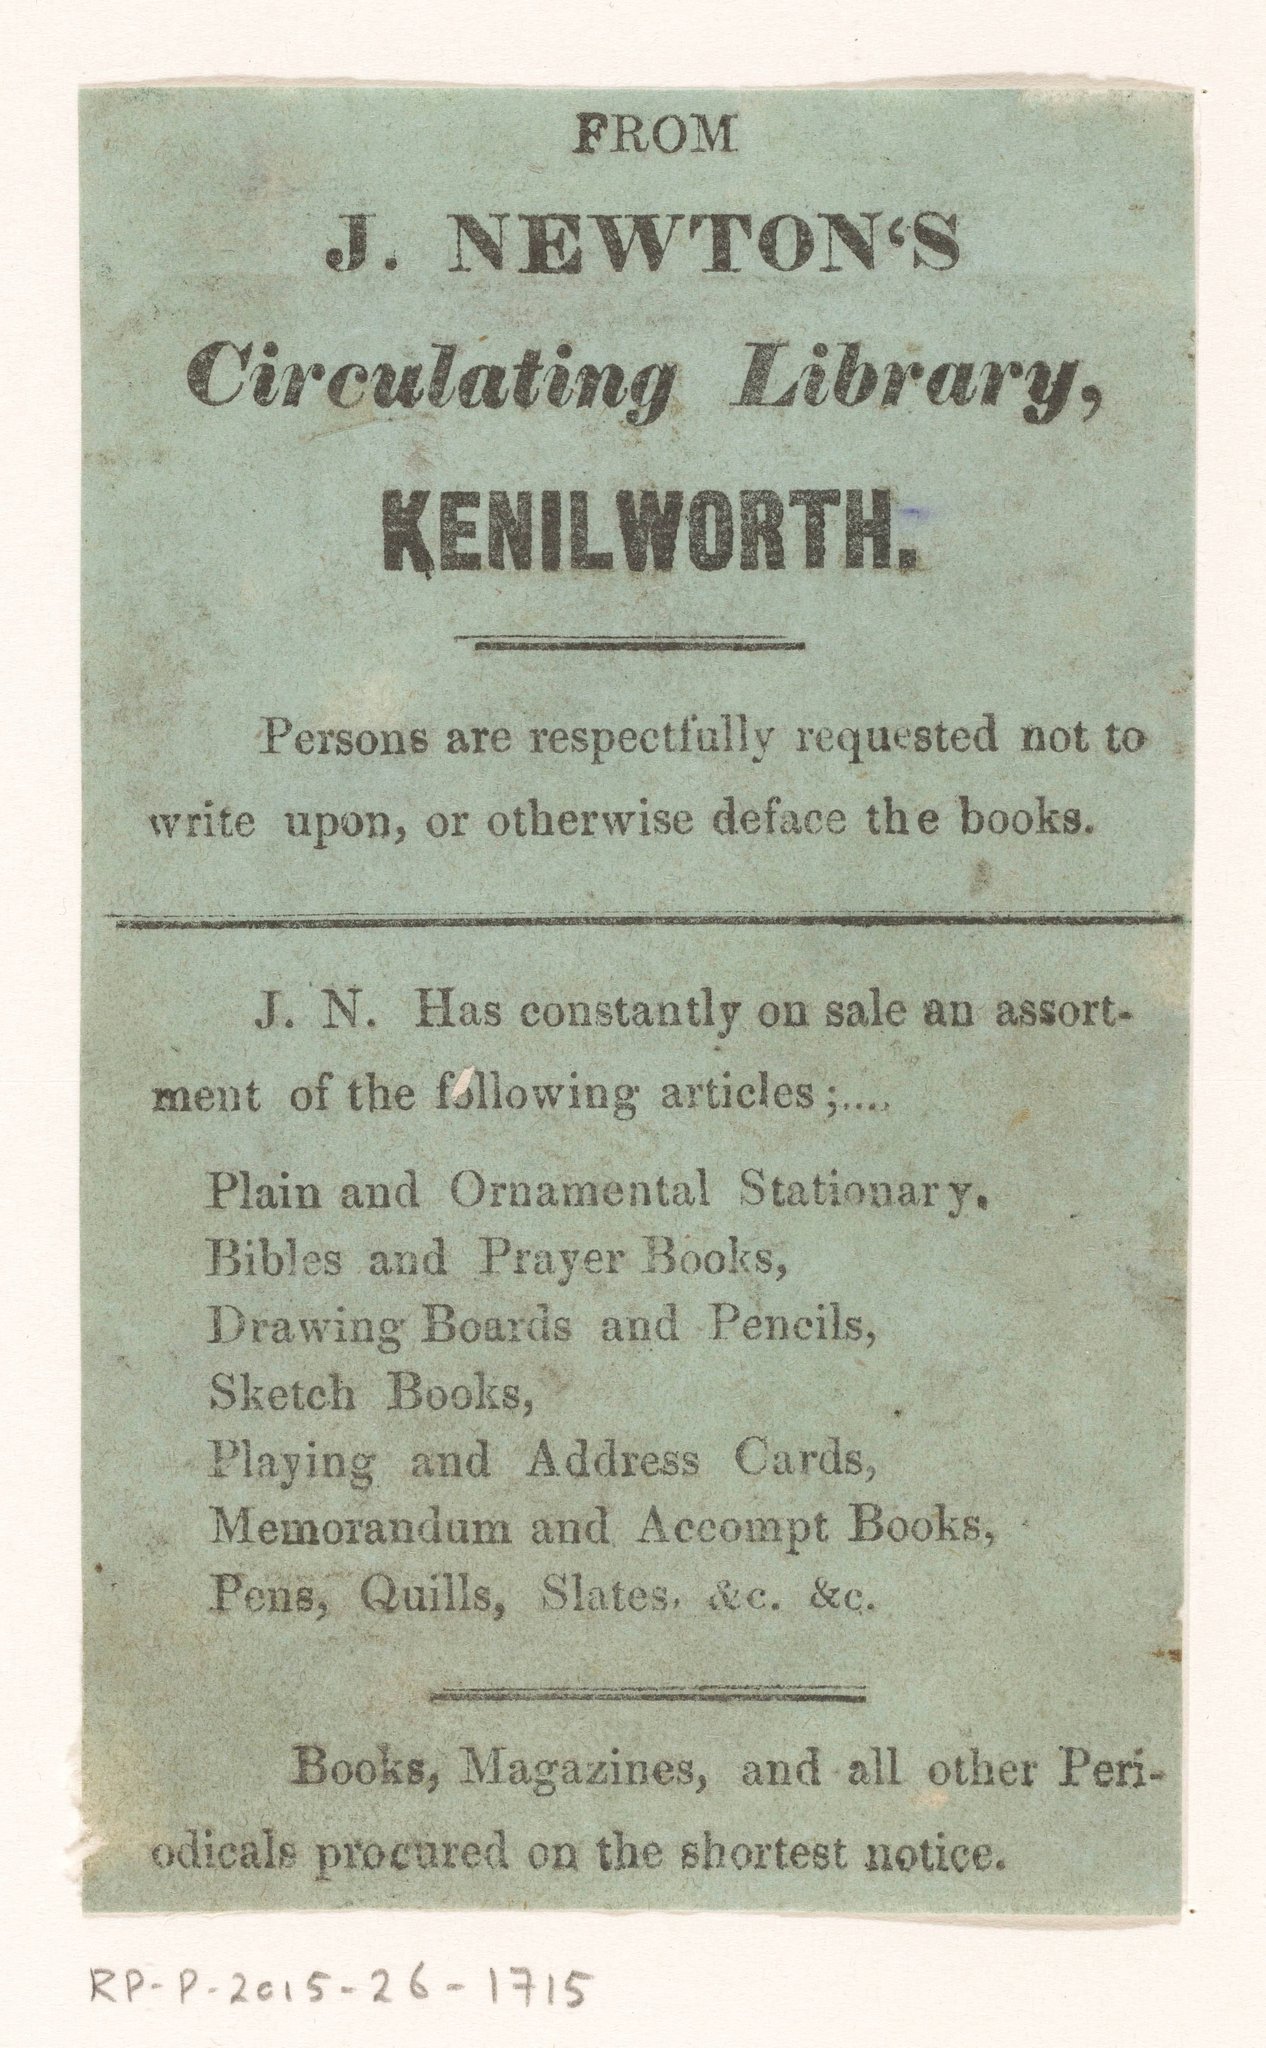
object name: print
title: Ex libris van J. Newton's Circulating Library te Kenilworth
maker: Anonymous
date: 1800-1899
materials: paper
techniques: letterpress printing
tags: kenilworth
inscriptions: collector's mark: Lugt 2228